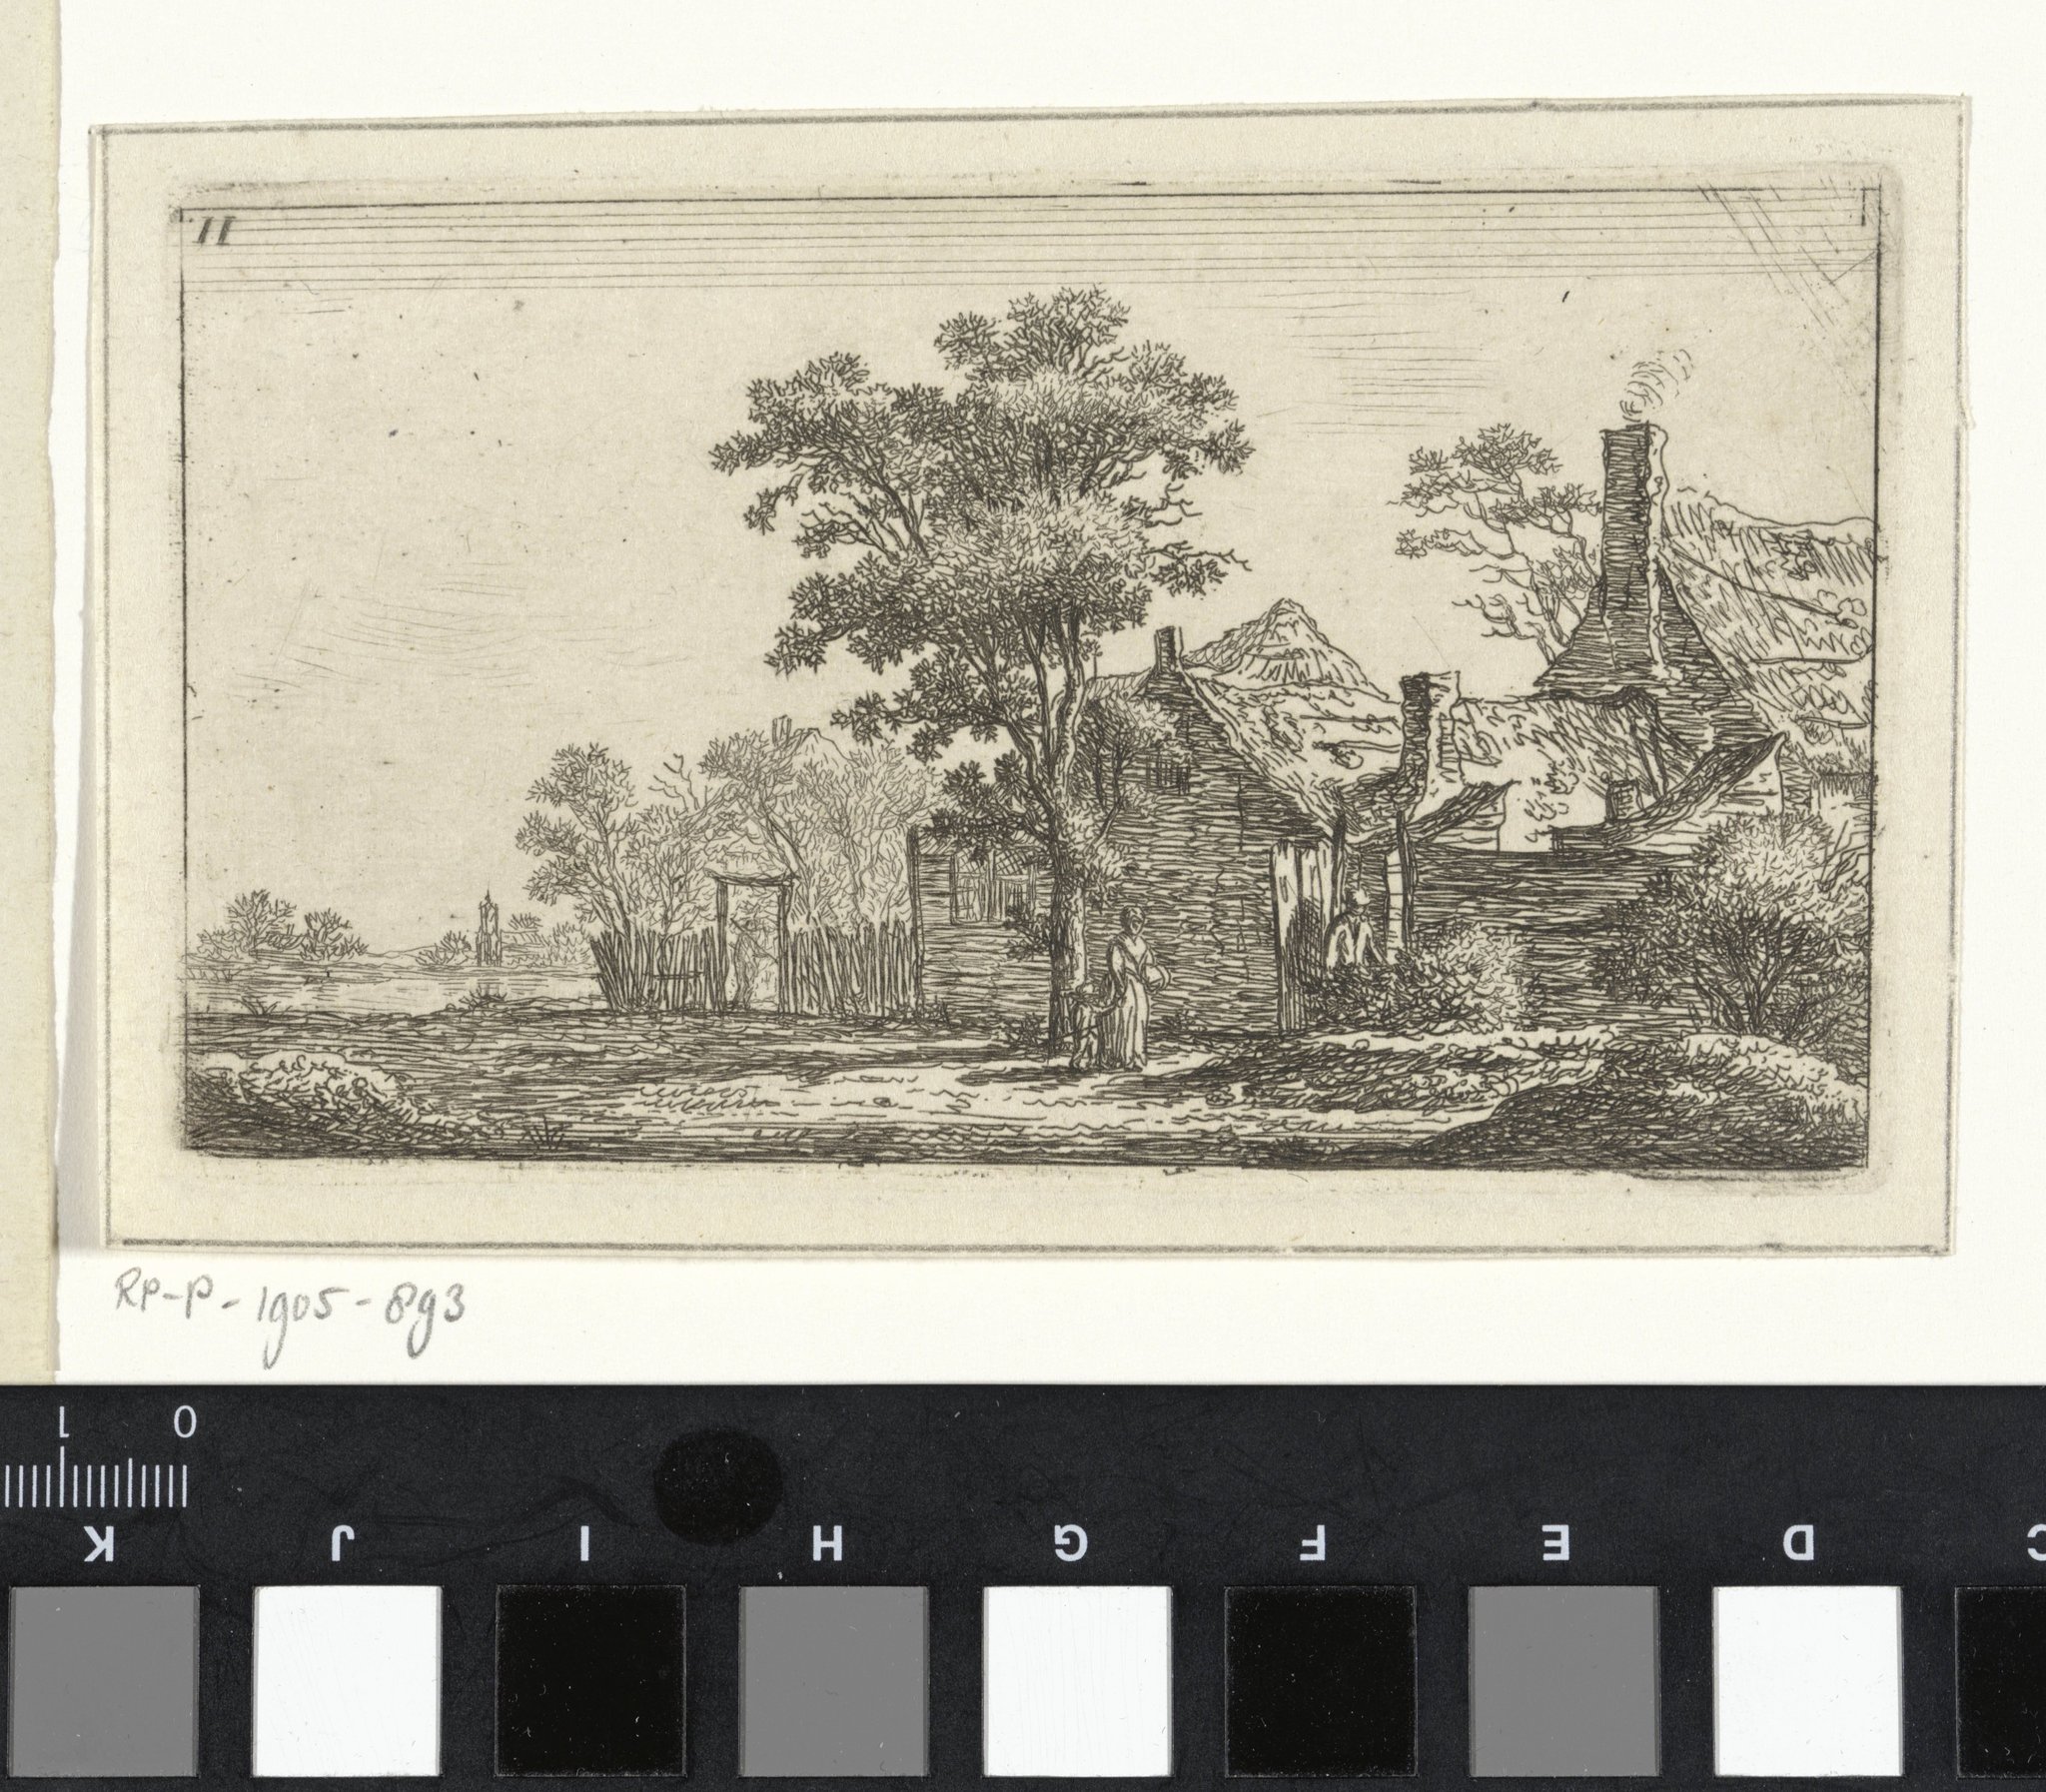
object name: print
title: Landschap met boerderijen en vrouw met kind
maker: hendrik schwegman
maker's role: draughtsman, print maker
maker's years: 1761-1816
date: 1786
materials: paper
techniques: etching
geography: haarlem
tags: farm or solitary house in landscape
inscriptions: collector's mark: Lugt 2228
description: Landschap met links enkele boerderijen. Een vrouw loopt met een kind aan de hand.